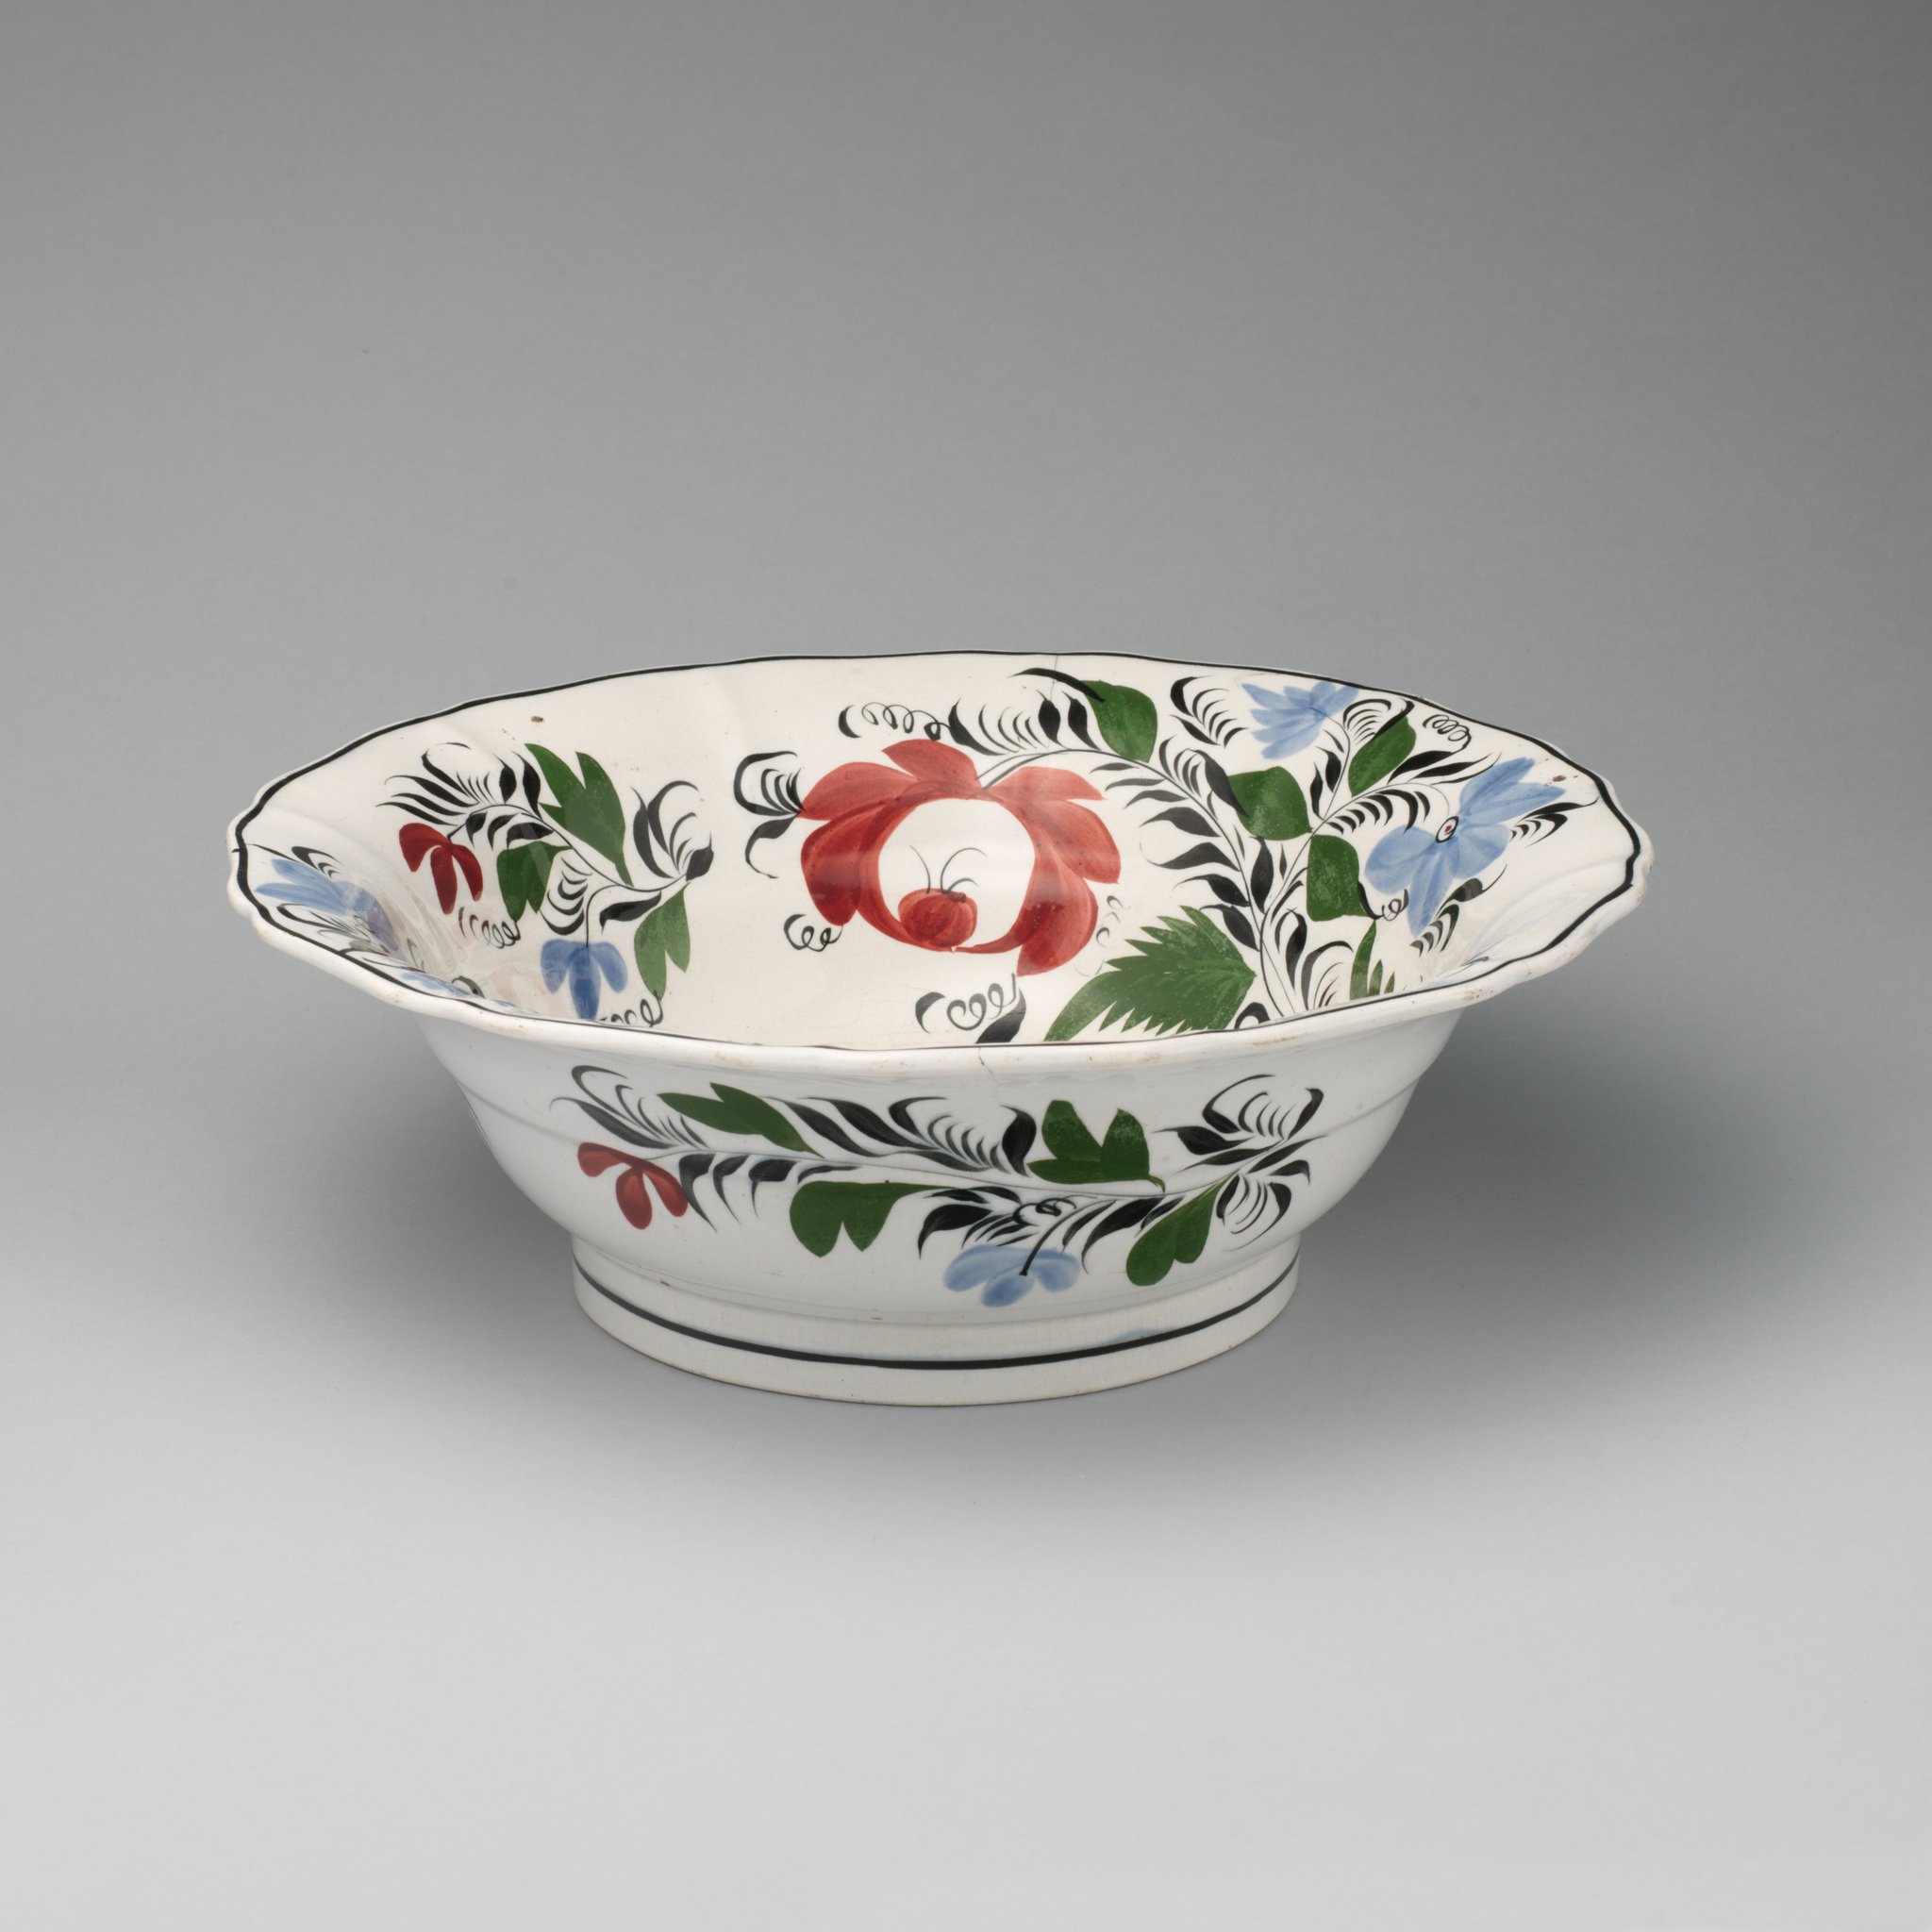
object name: bowl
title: Bowl (part of a set)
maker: william adams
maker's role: maker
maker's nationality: british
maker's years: 1798-1865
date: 1801-1900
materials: earthenware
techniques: glazing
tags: flowers